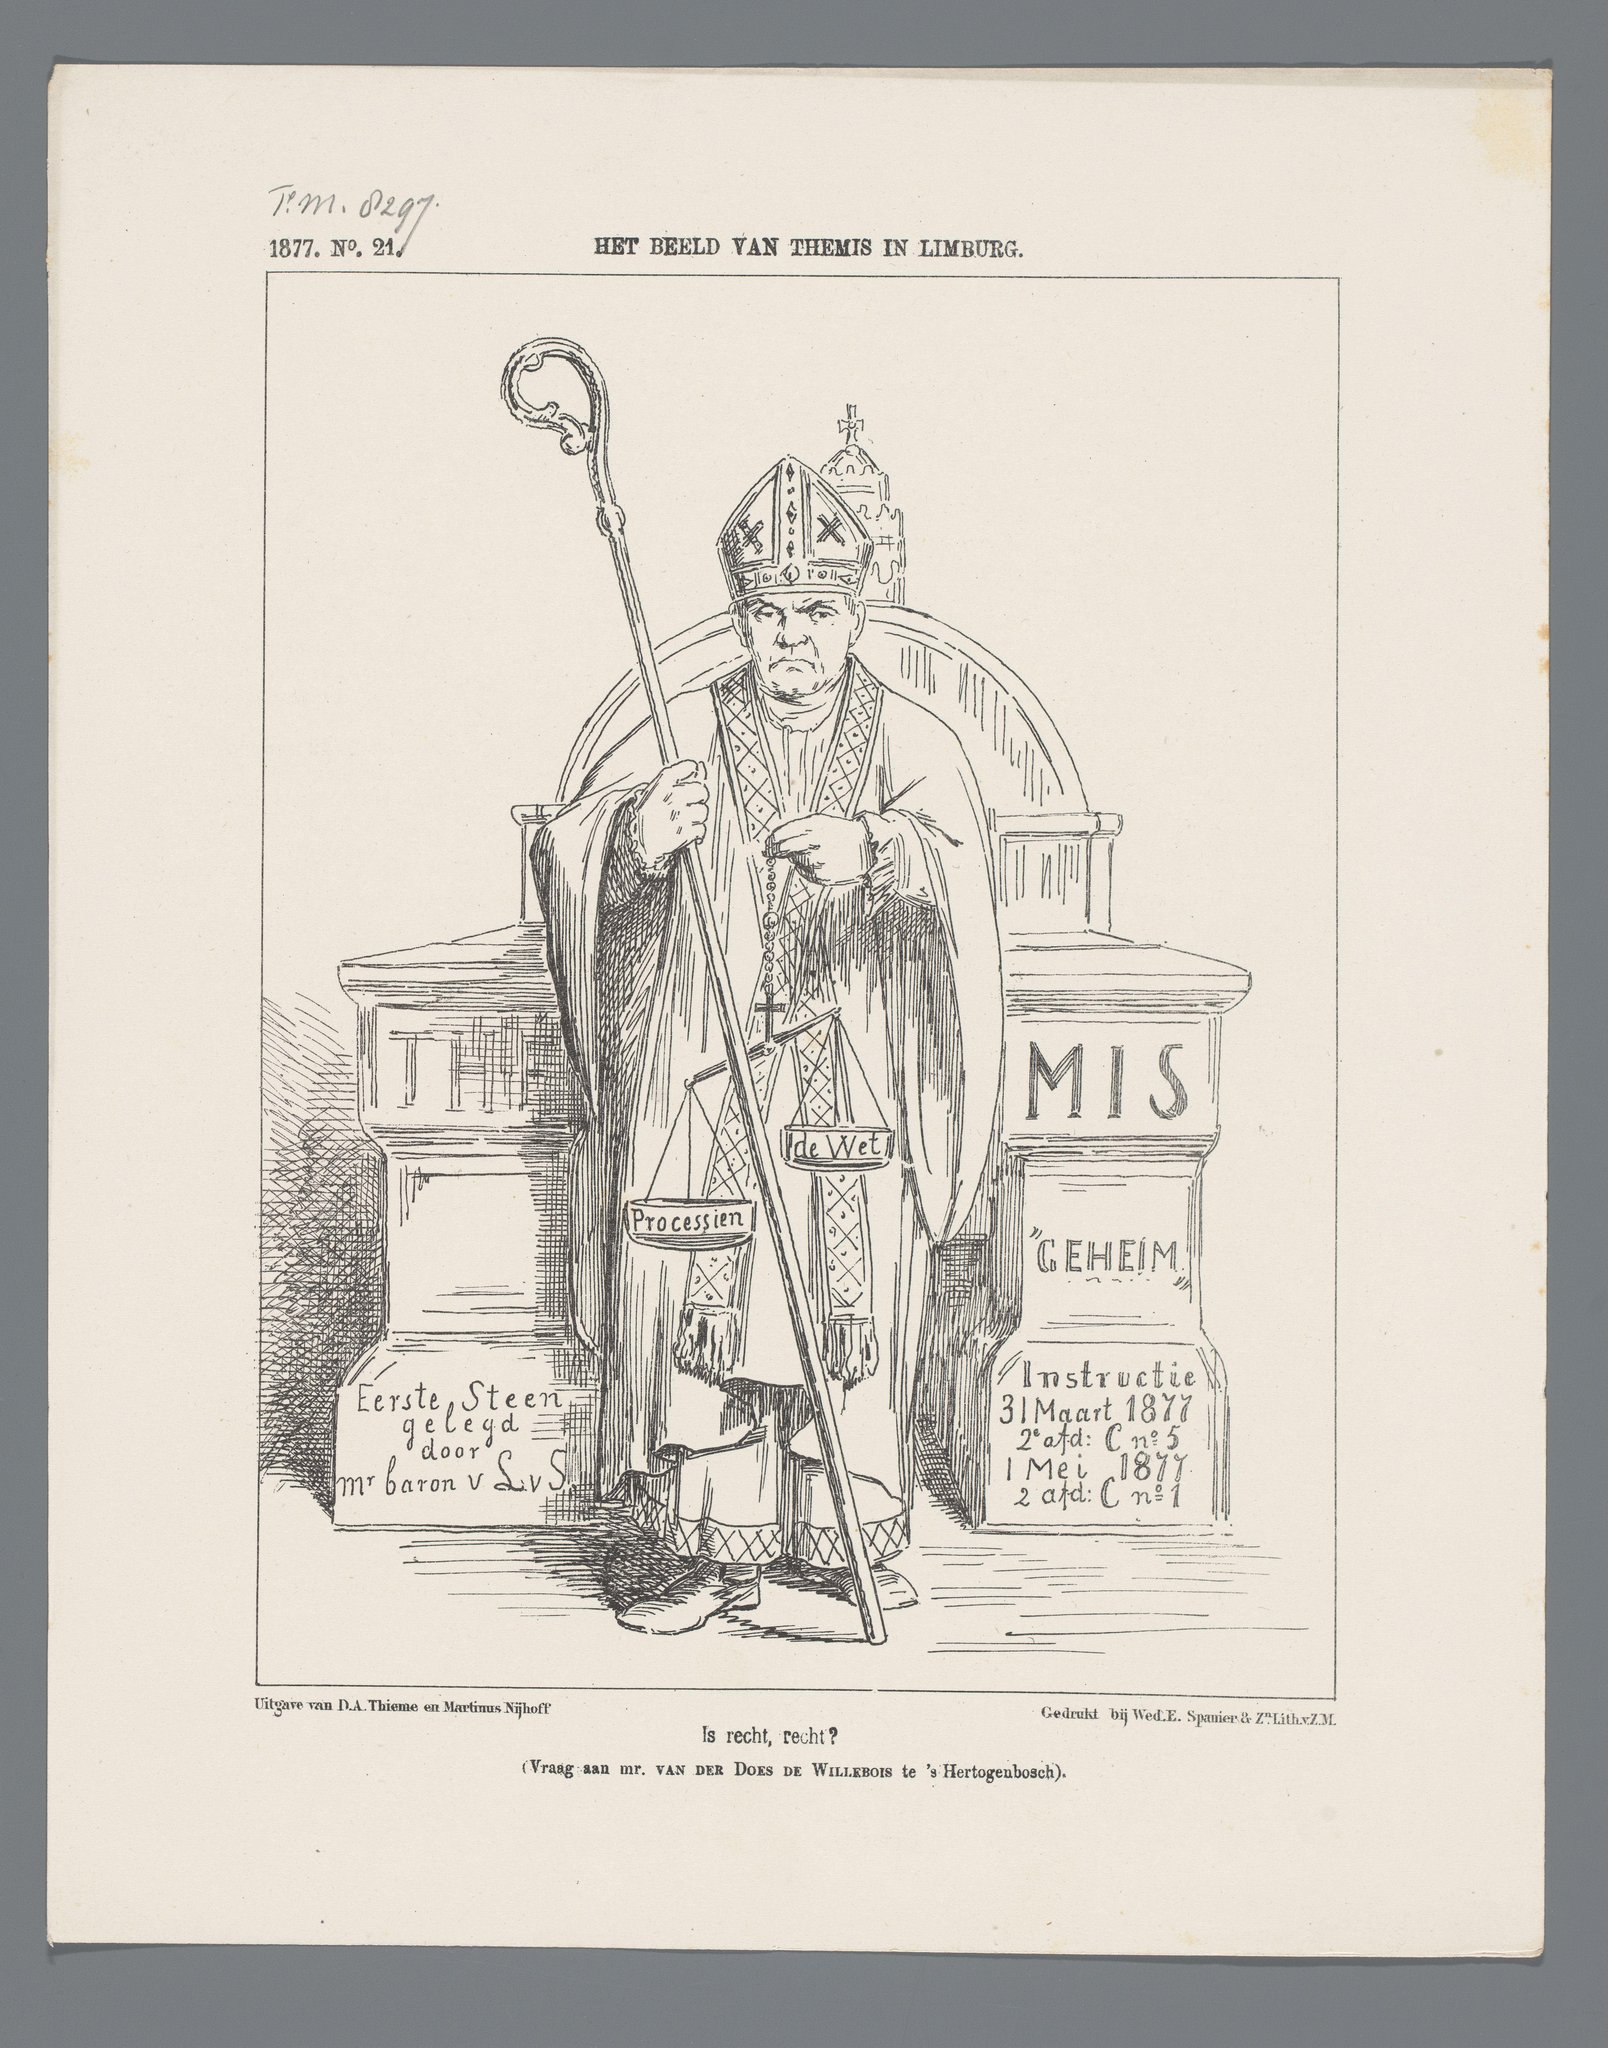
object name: print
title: Spotprent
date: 1877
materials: paper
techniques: lithograph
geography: netherlands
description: Spotprent . Plaat verschenen bij het weekblad De Nederlandsche Spectator, nr. 21, 1877.